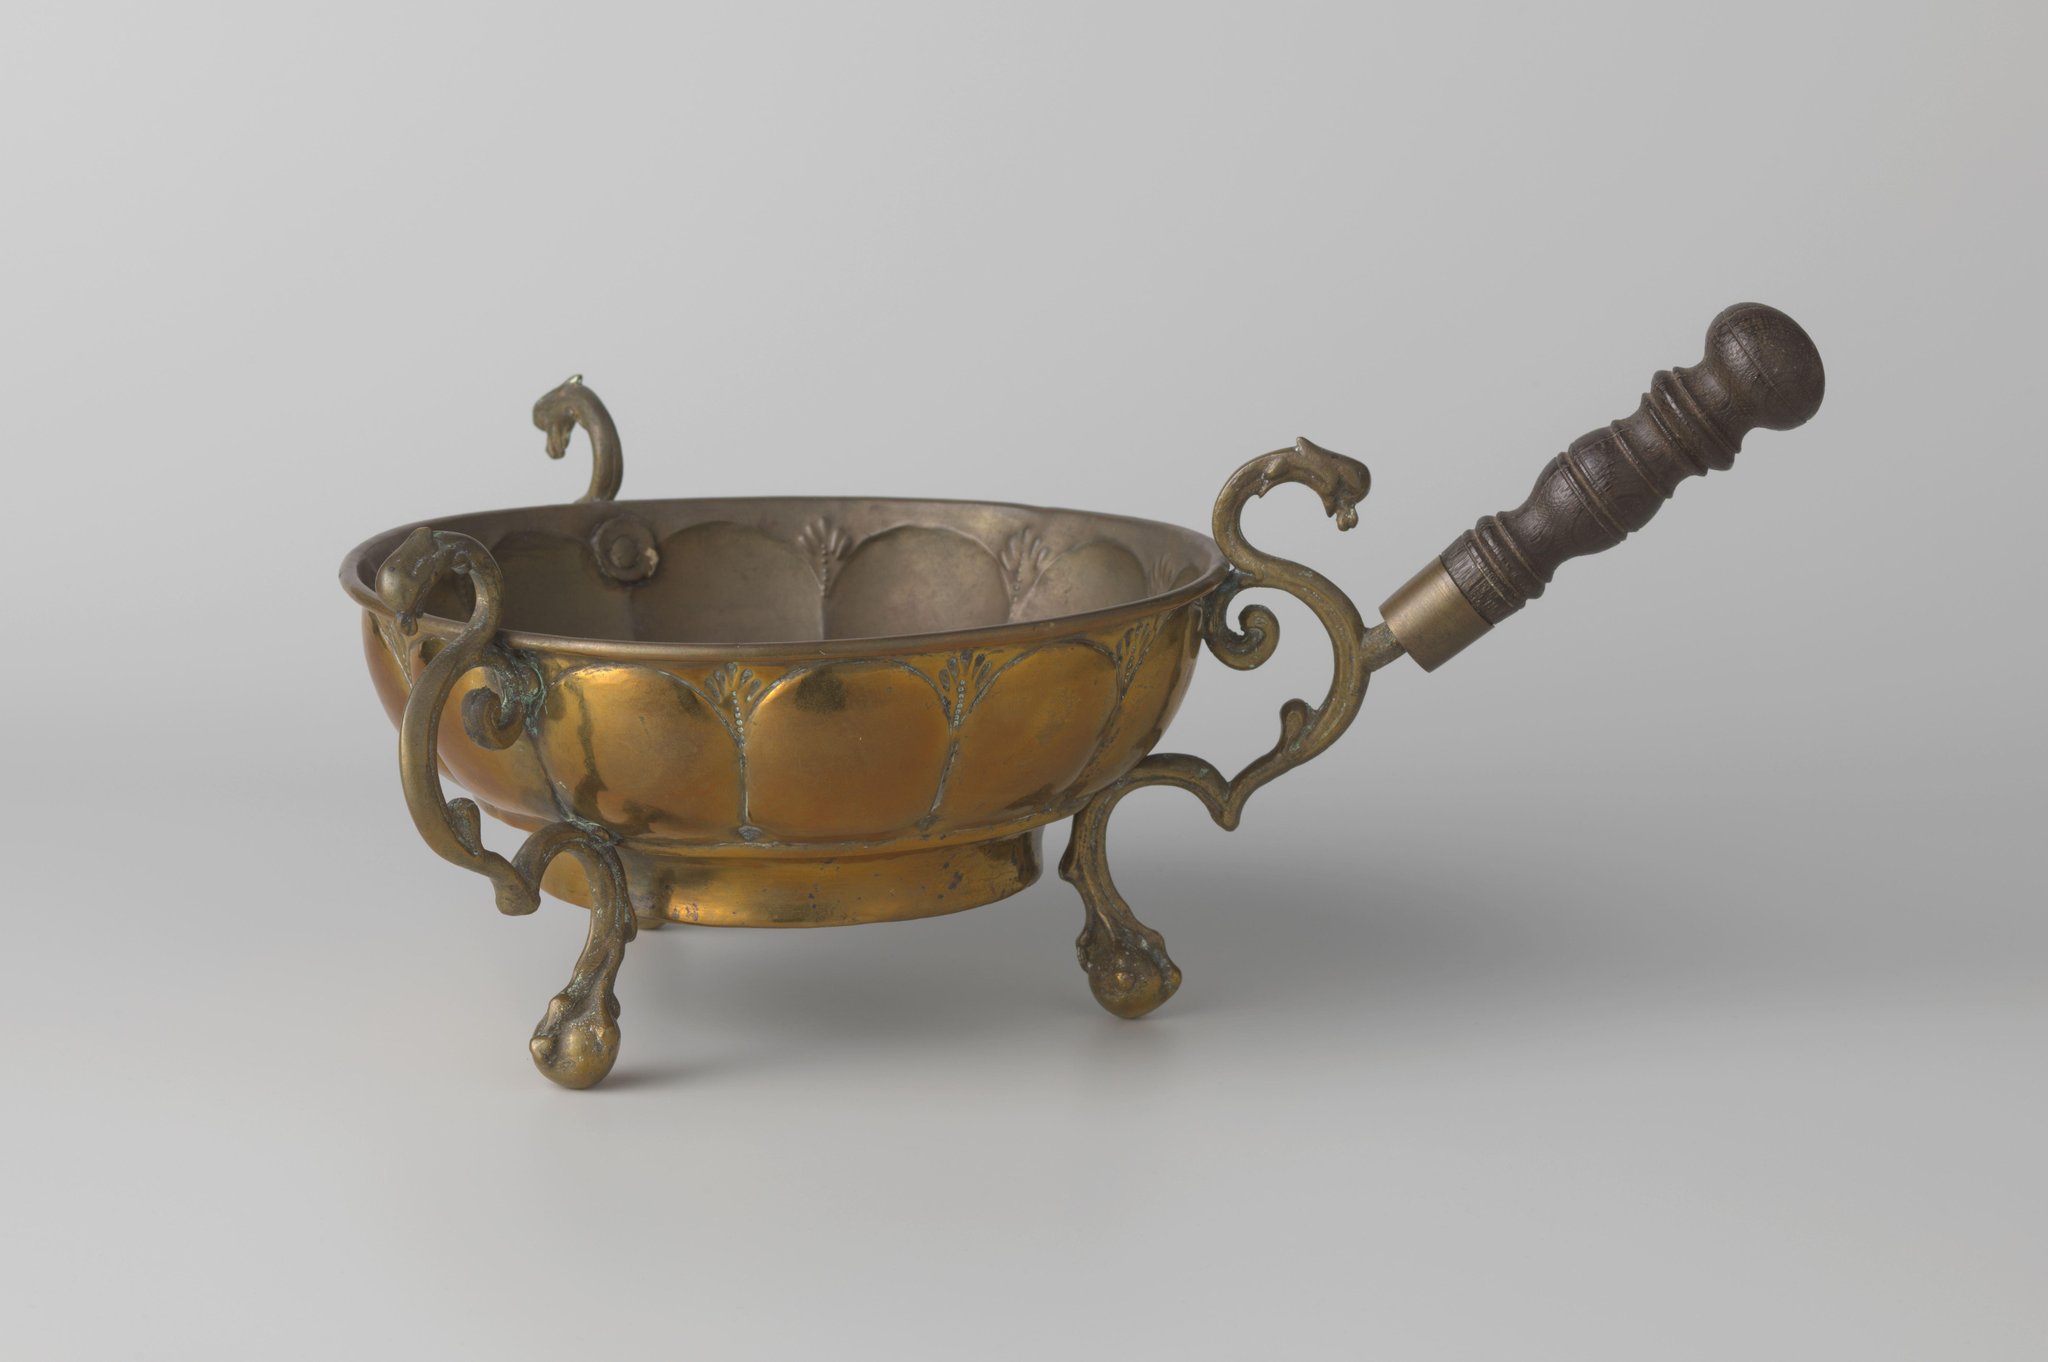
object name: komfoor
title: Komfoor van messing en hout.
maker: Anonymous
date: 1650-1675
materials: brass, copper, wood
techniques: casting, sawing, screwed, turning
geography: netherlands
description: Het voorwerp heeft een gedraaid houten handvat en bestaat uit de volgende gegoten of uit plaat gedraaide en gedreven of uitgezaagde onderdelen: de met twaalf lobben versierde bak, waarin met een bout en een moer een stervormig uitgesneden bodemplaat van rood koper is geschroefd en waartegen de drie verticale op klauwpoten staande, in- en uitgezwenkte en in vogelkoppen eindigende delen zijn geklonken.